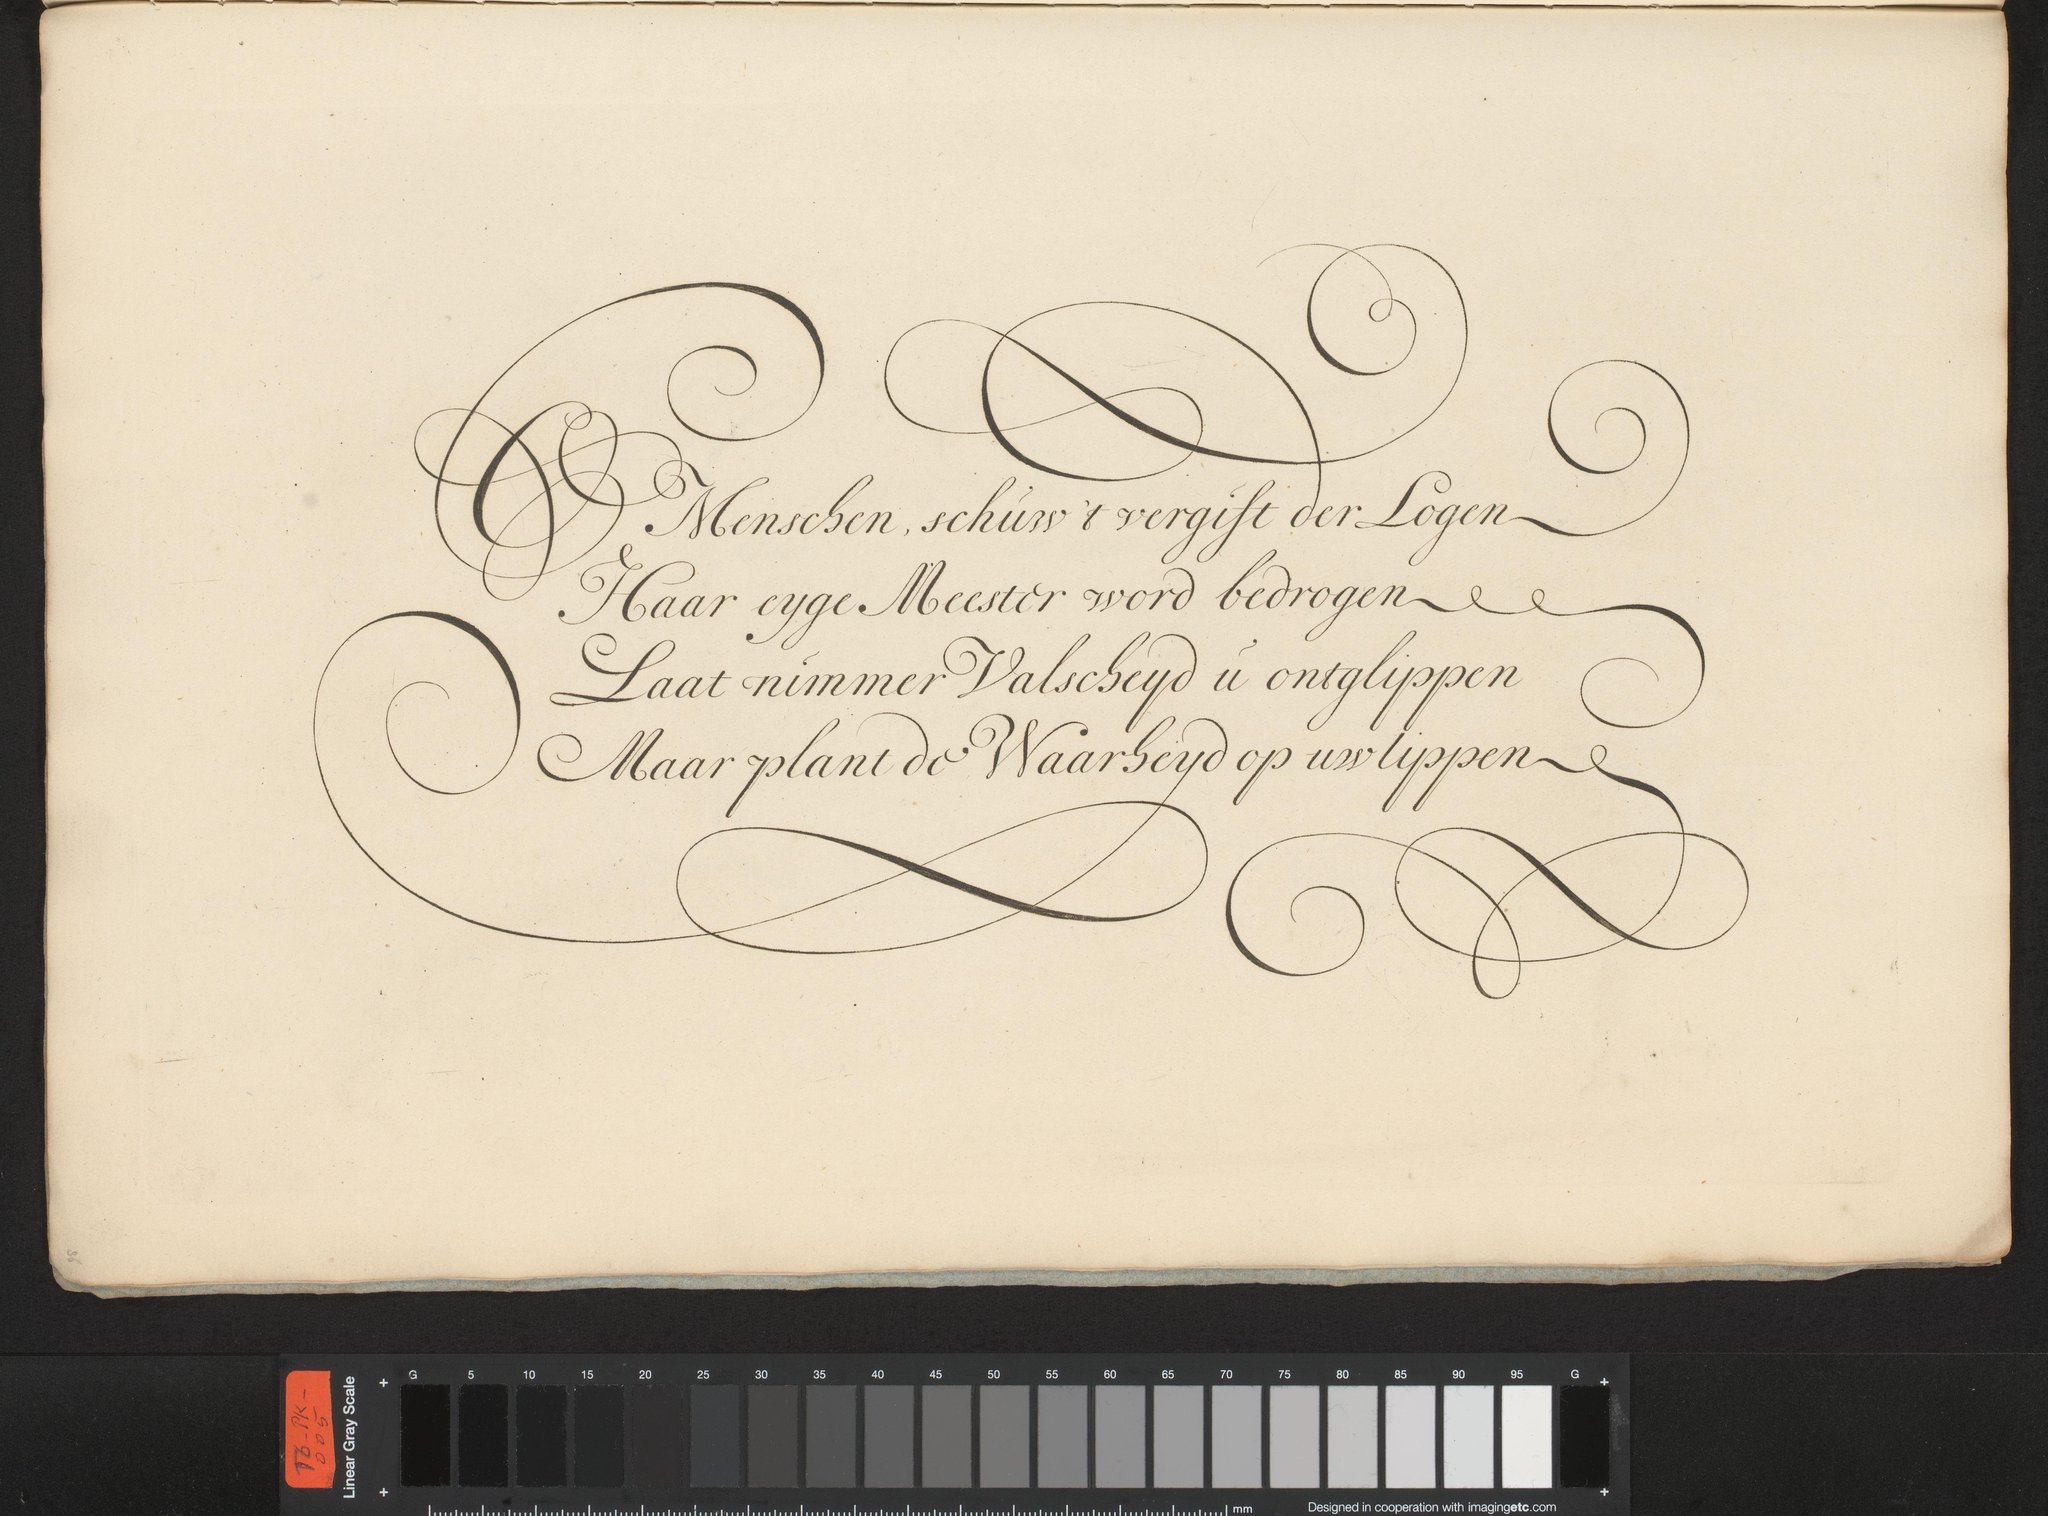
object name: album leaf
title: Schrijfvoorbeeld: O Menschen, schuw 't vergift der Logen (...)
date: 1660-1751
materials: paper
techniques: engraving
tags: calligraphy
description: Schrijfvoorbeeld met vier regels tekst in het Nederlands: O Menschen, schuw 't vergift der Logen ... De prent maakt deel uit van een album